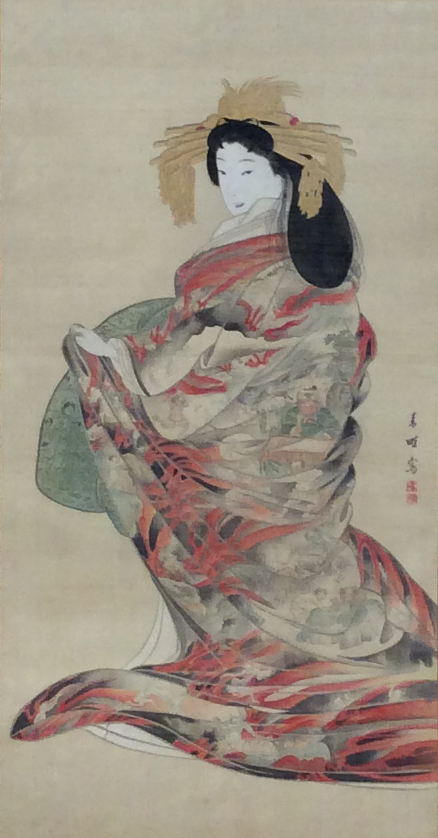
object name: hanging scroll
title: The Hell Courtesan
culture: japanese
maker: seikei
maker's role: artist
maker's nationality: japanese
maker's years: 1850-1899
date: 1867-1900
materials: ink, silk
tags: women